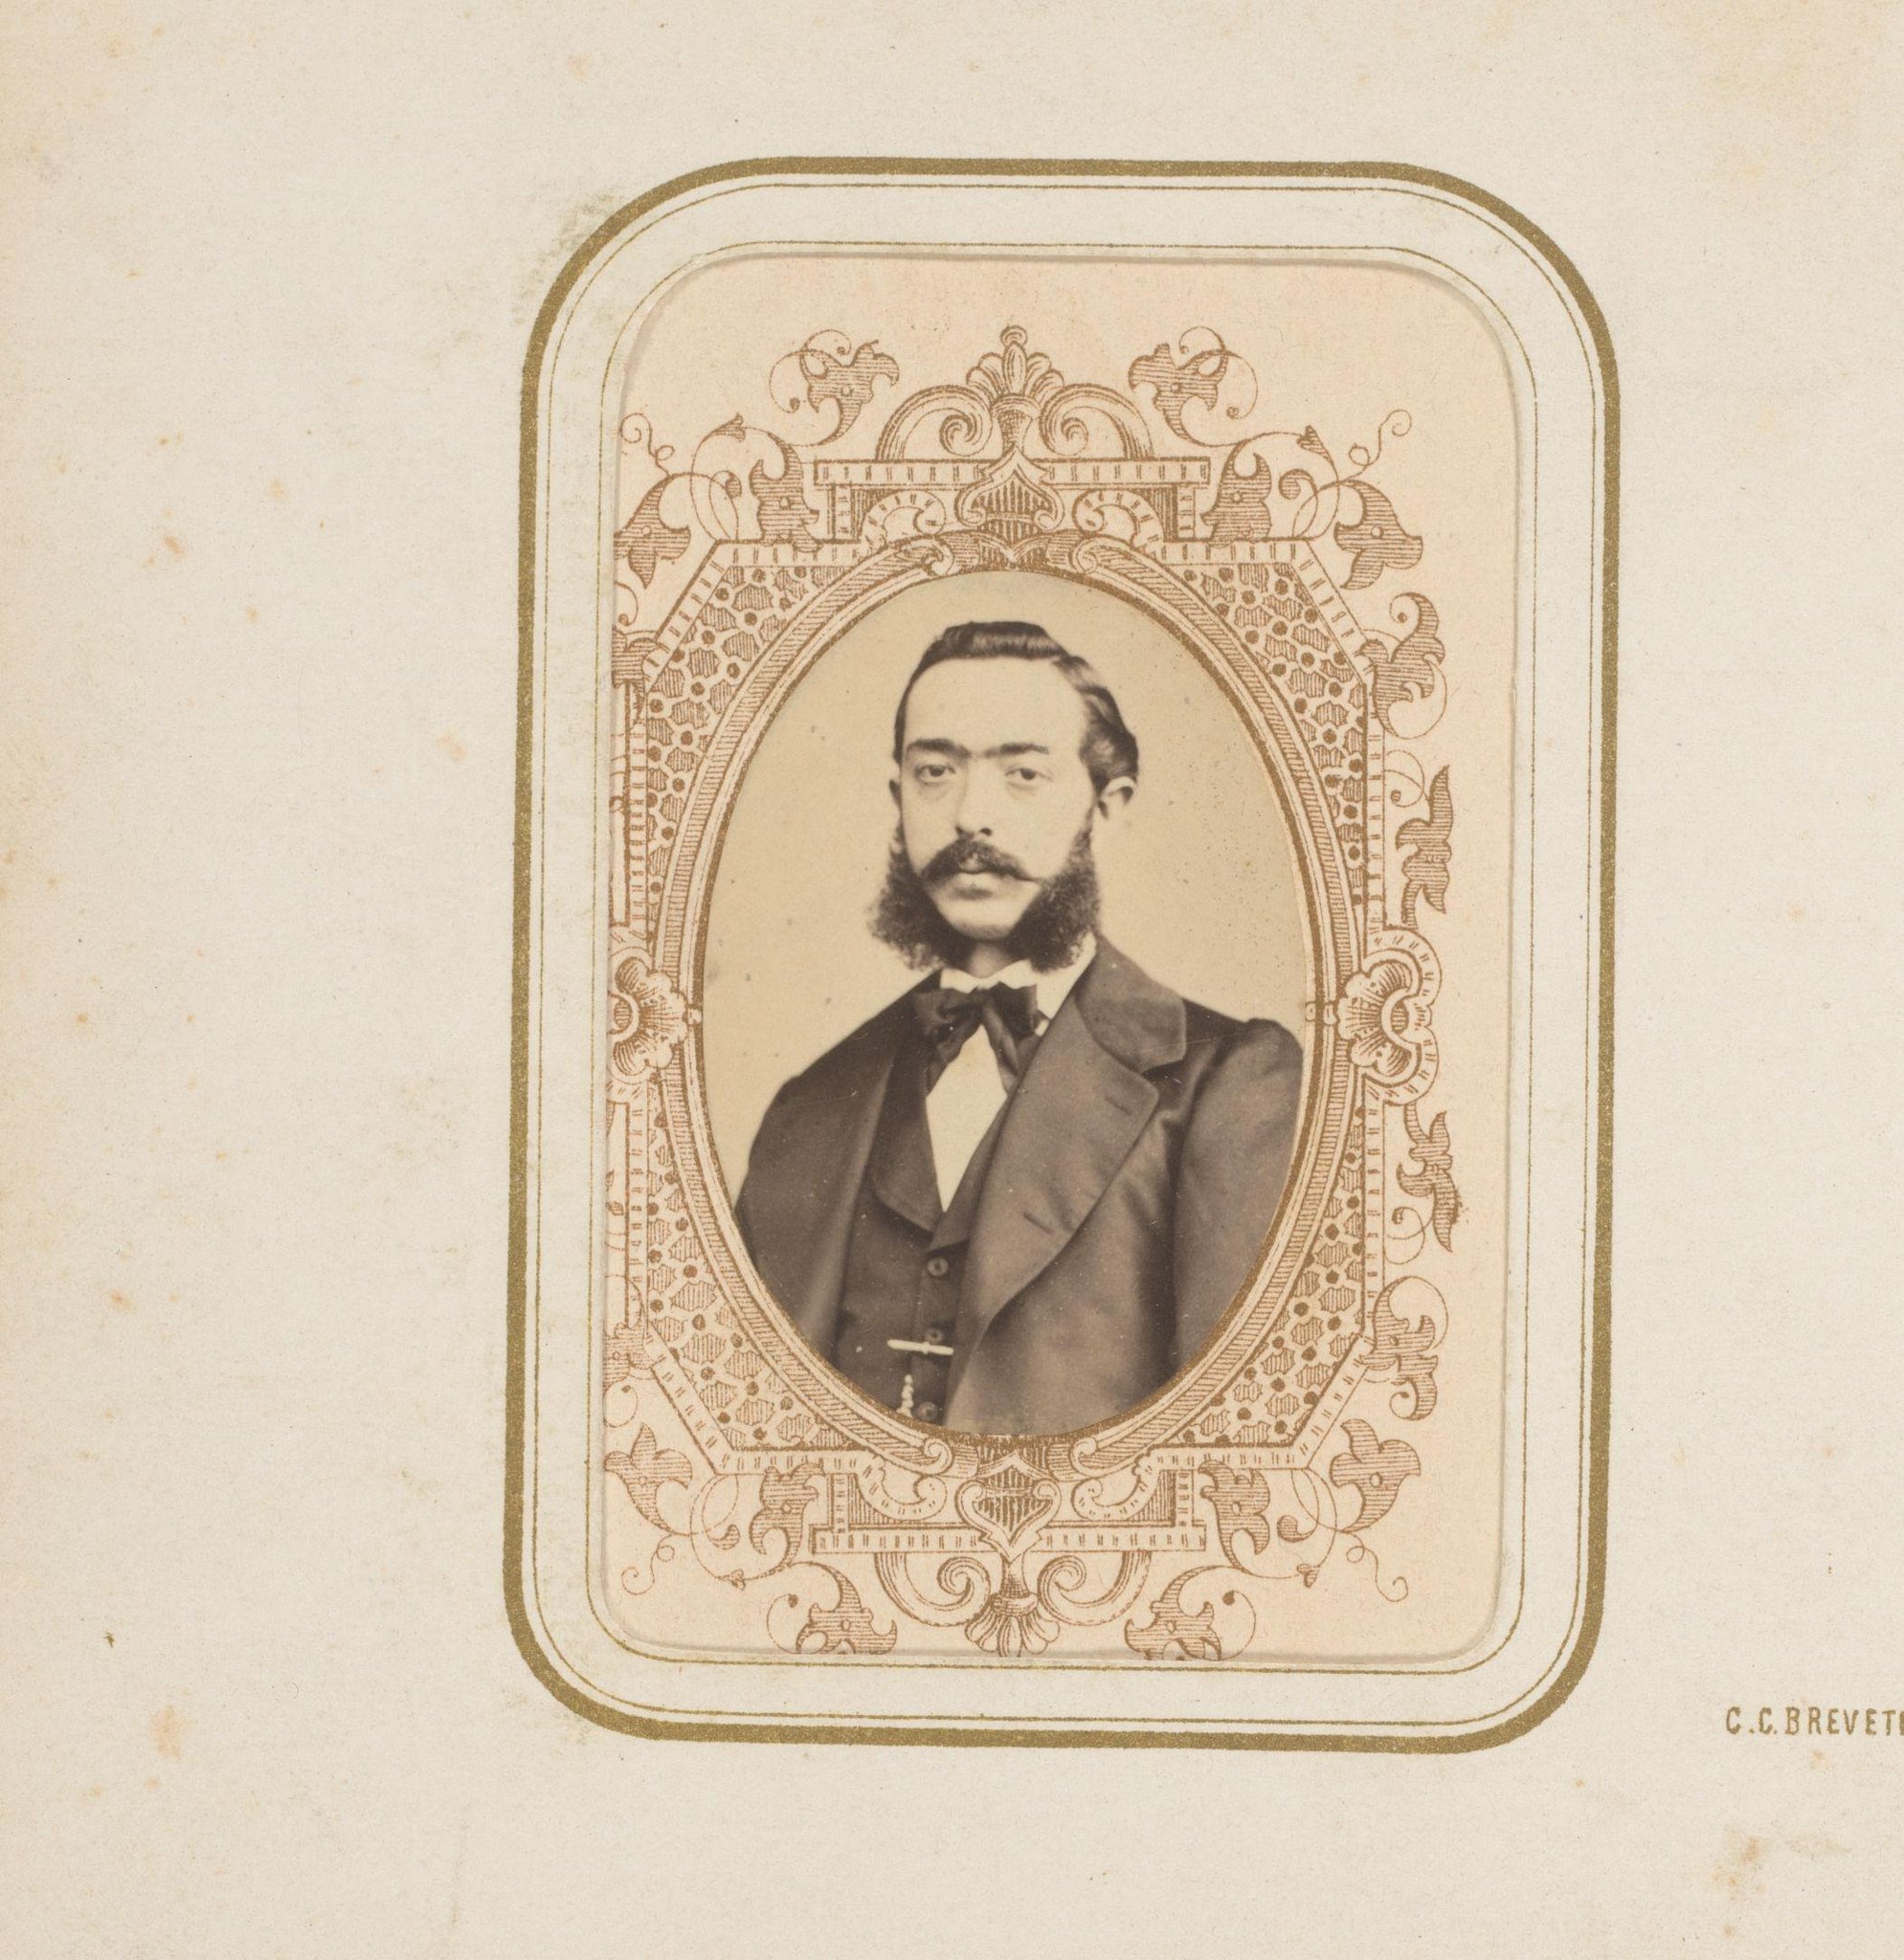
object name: carte de visite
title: Portret van een man met snor en bakkenbaarden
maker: Anonymous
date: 1860-1900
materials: cardboard, photographic support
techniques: albumen print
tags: sideburns, moustache, adult man, historical persons